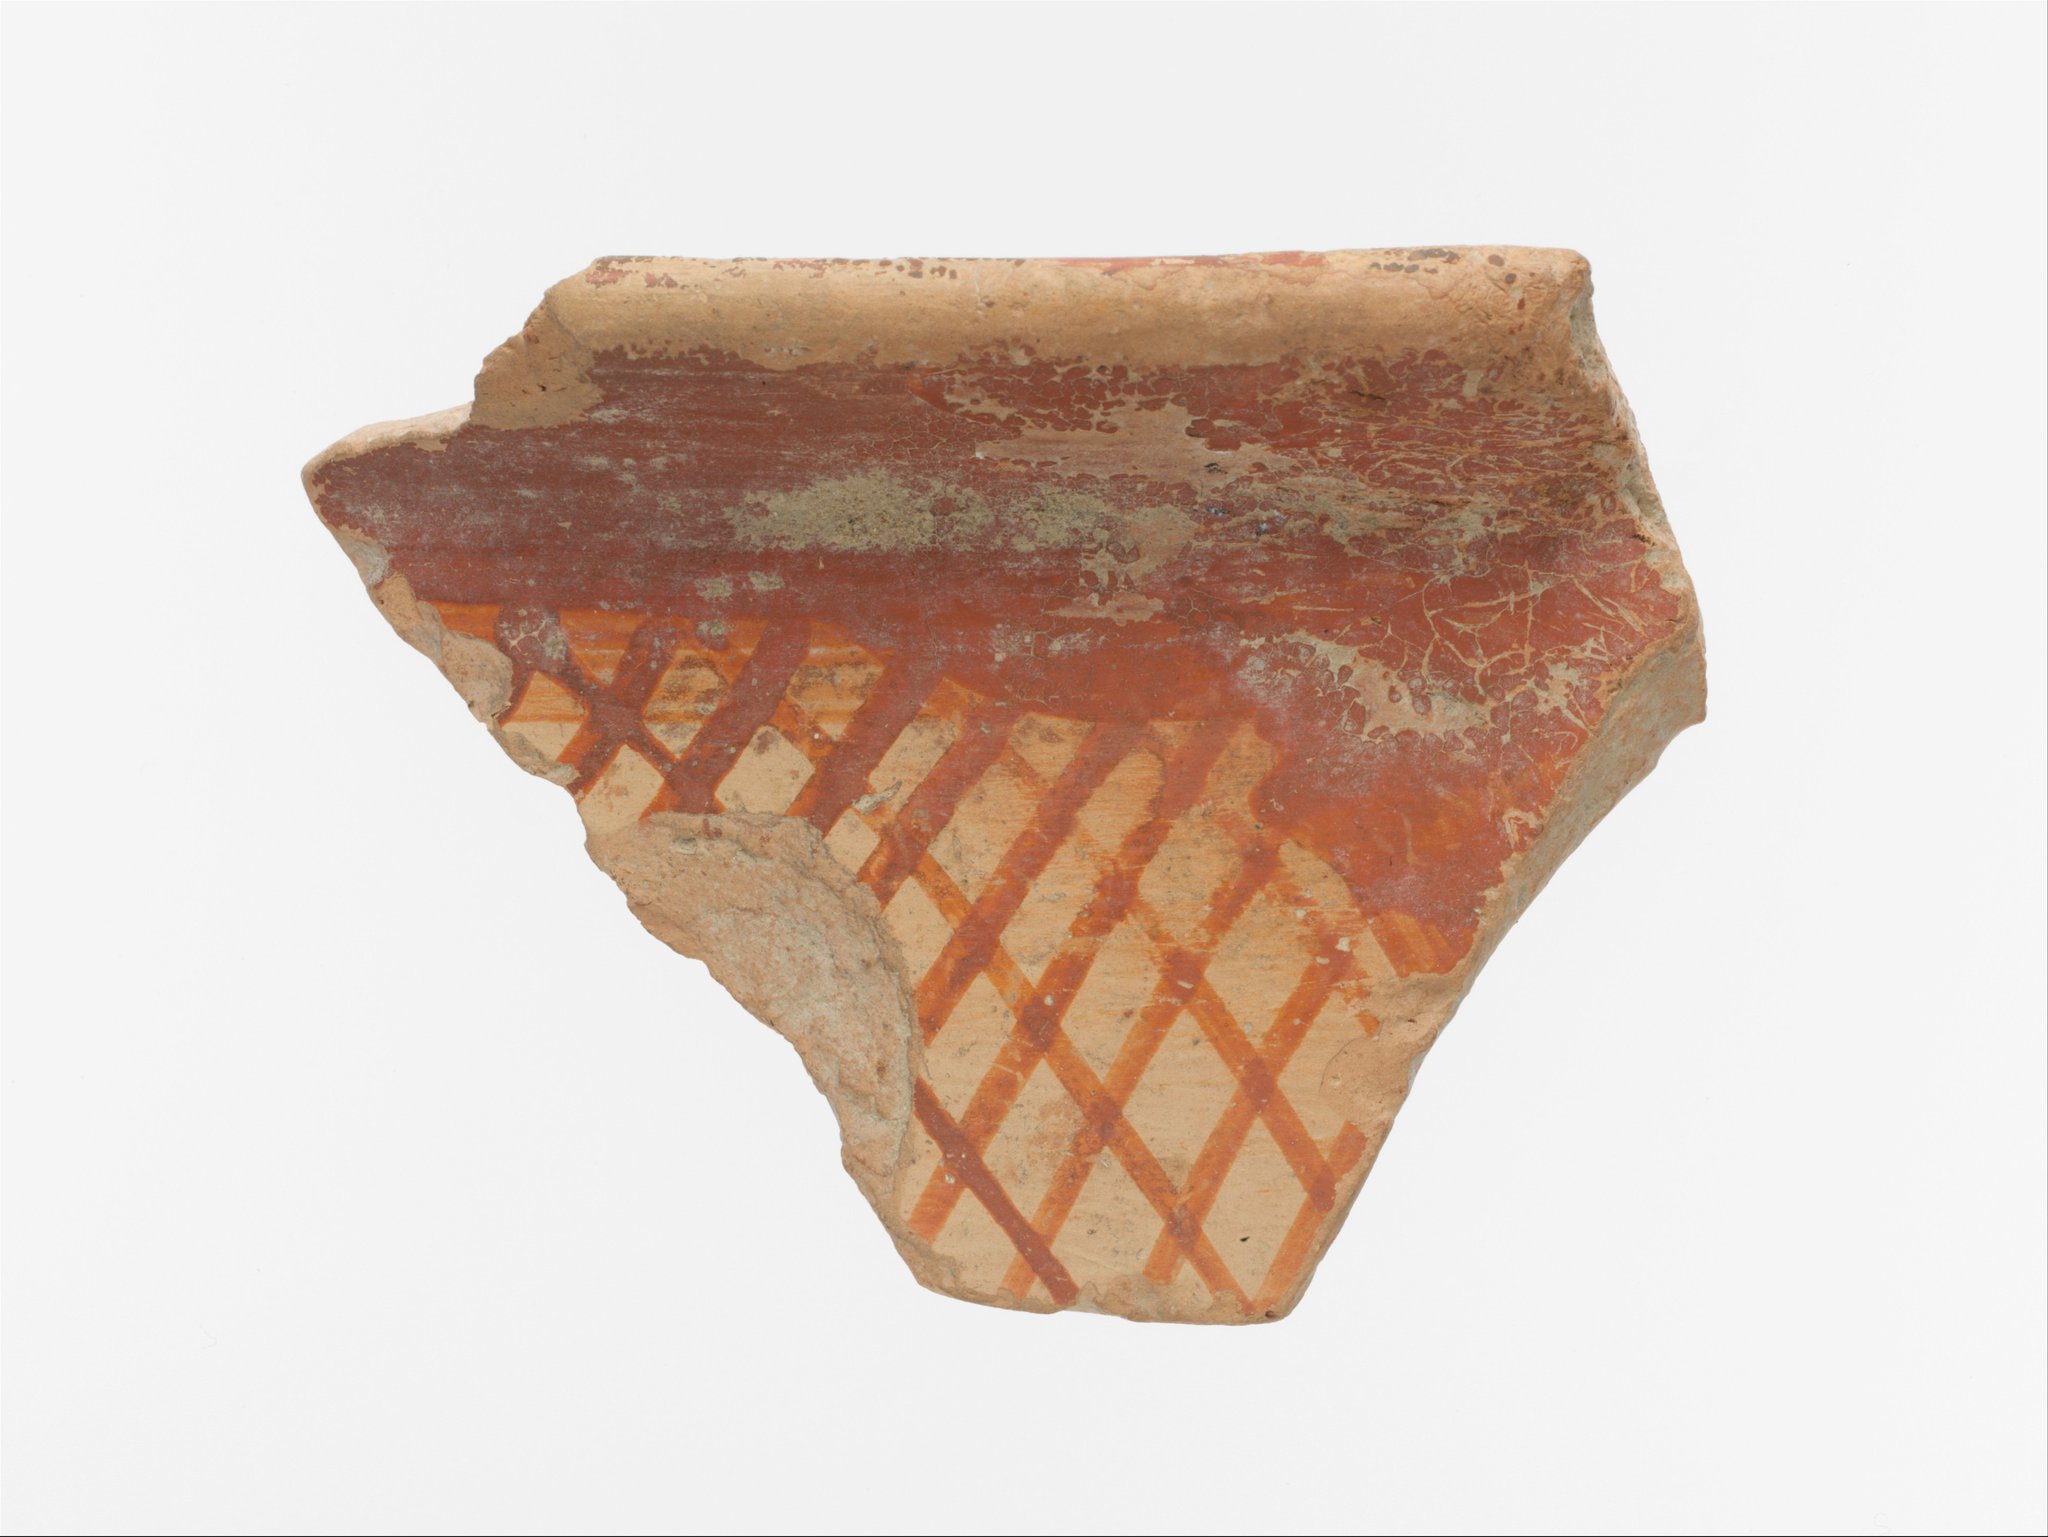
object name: vase fragment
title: Terracotta rim fragment with cross-hatching beneath band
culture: mycenaean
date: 1400 BCE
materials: terracotta